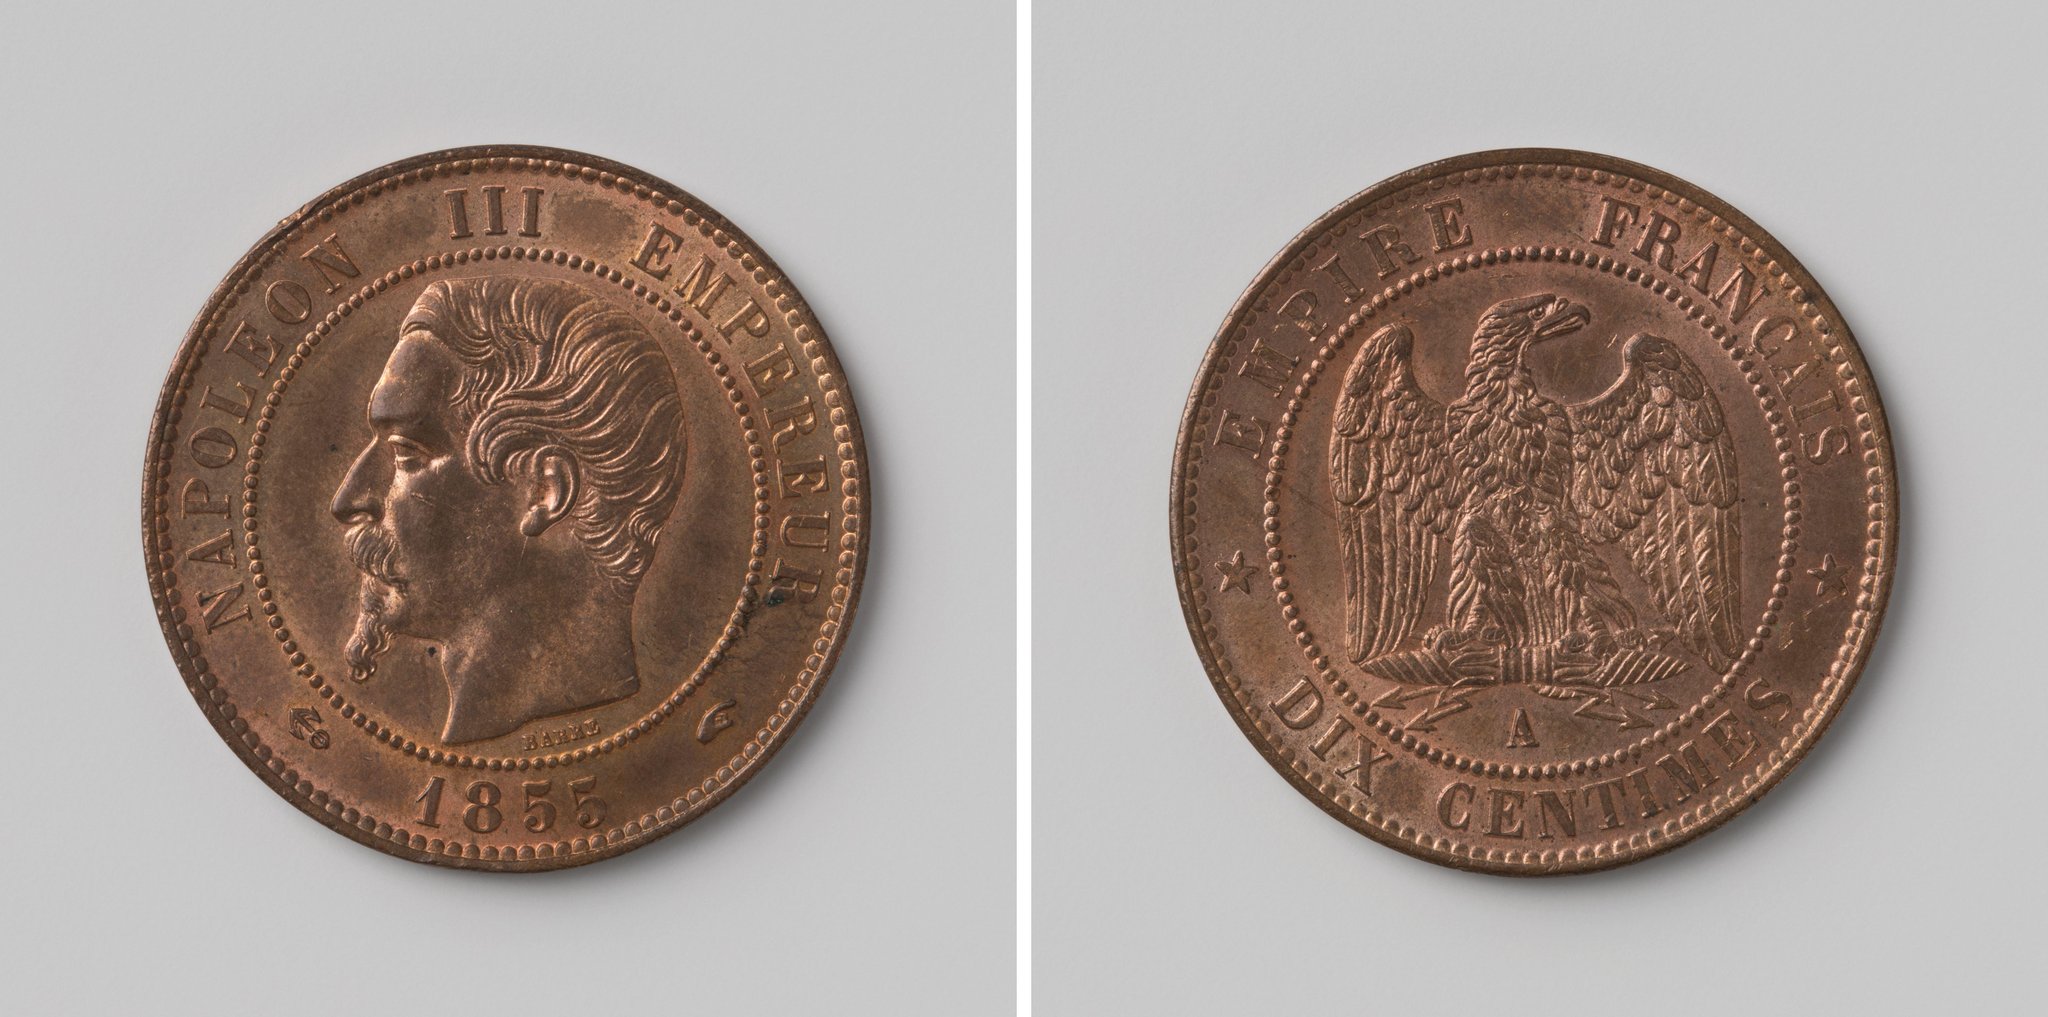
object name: coin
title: Tien centimes van Napoleon III Bonaparte, keizer der Fransen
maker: jean jacques barre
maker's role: print maker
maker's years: 1793-1855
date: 1855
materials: copper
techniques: striking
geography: paris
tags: paris, london, napoleon iii (keizer der fransen)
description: Voorzijde: borststuk man naar links boven signatuur binnen omschrift. Keerzijde: adelaar met gespreide vleugels, naar rechts gewende kop en donder en bliksemschichten in klauwen; daaronder: letter A binnen omschrift